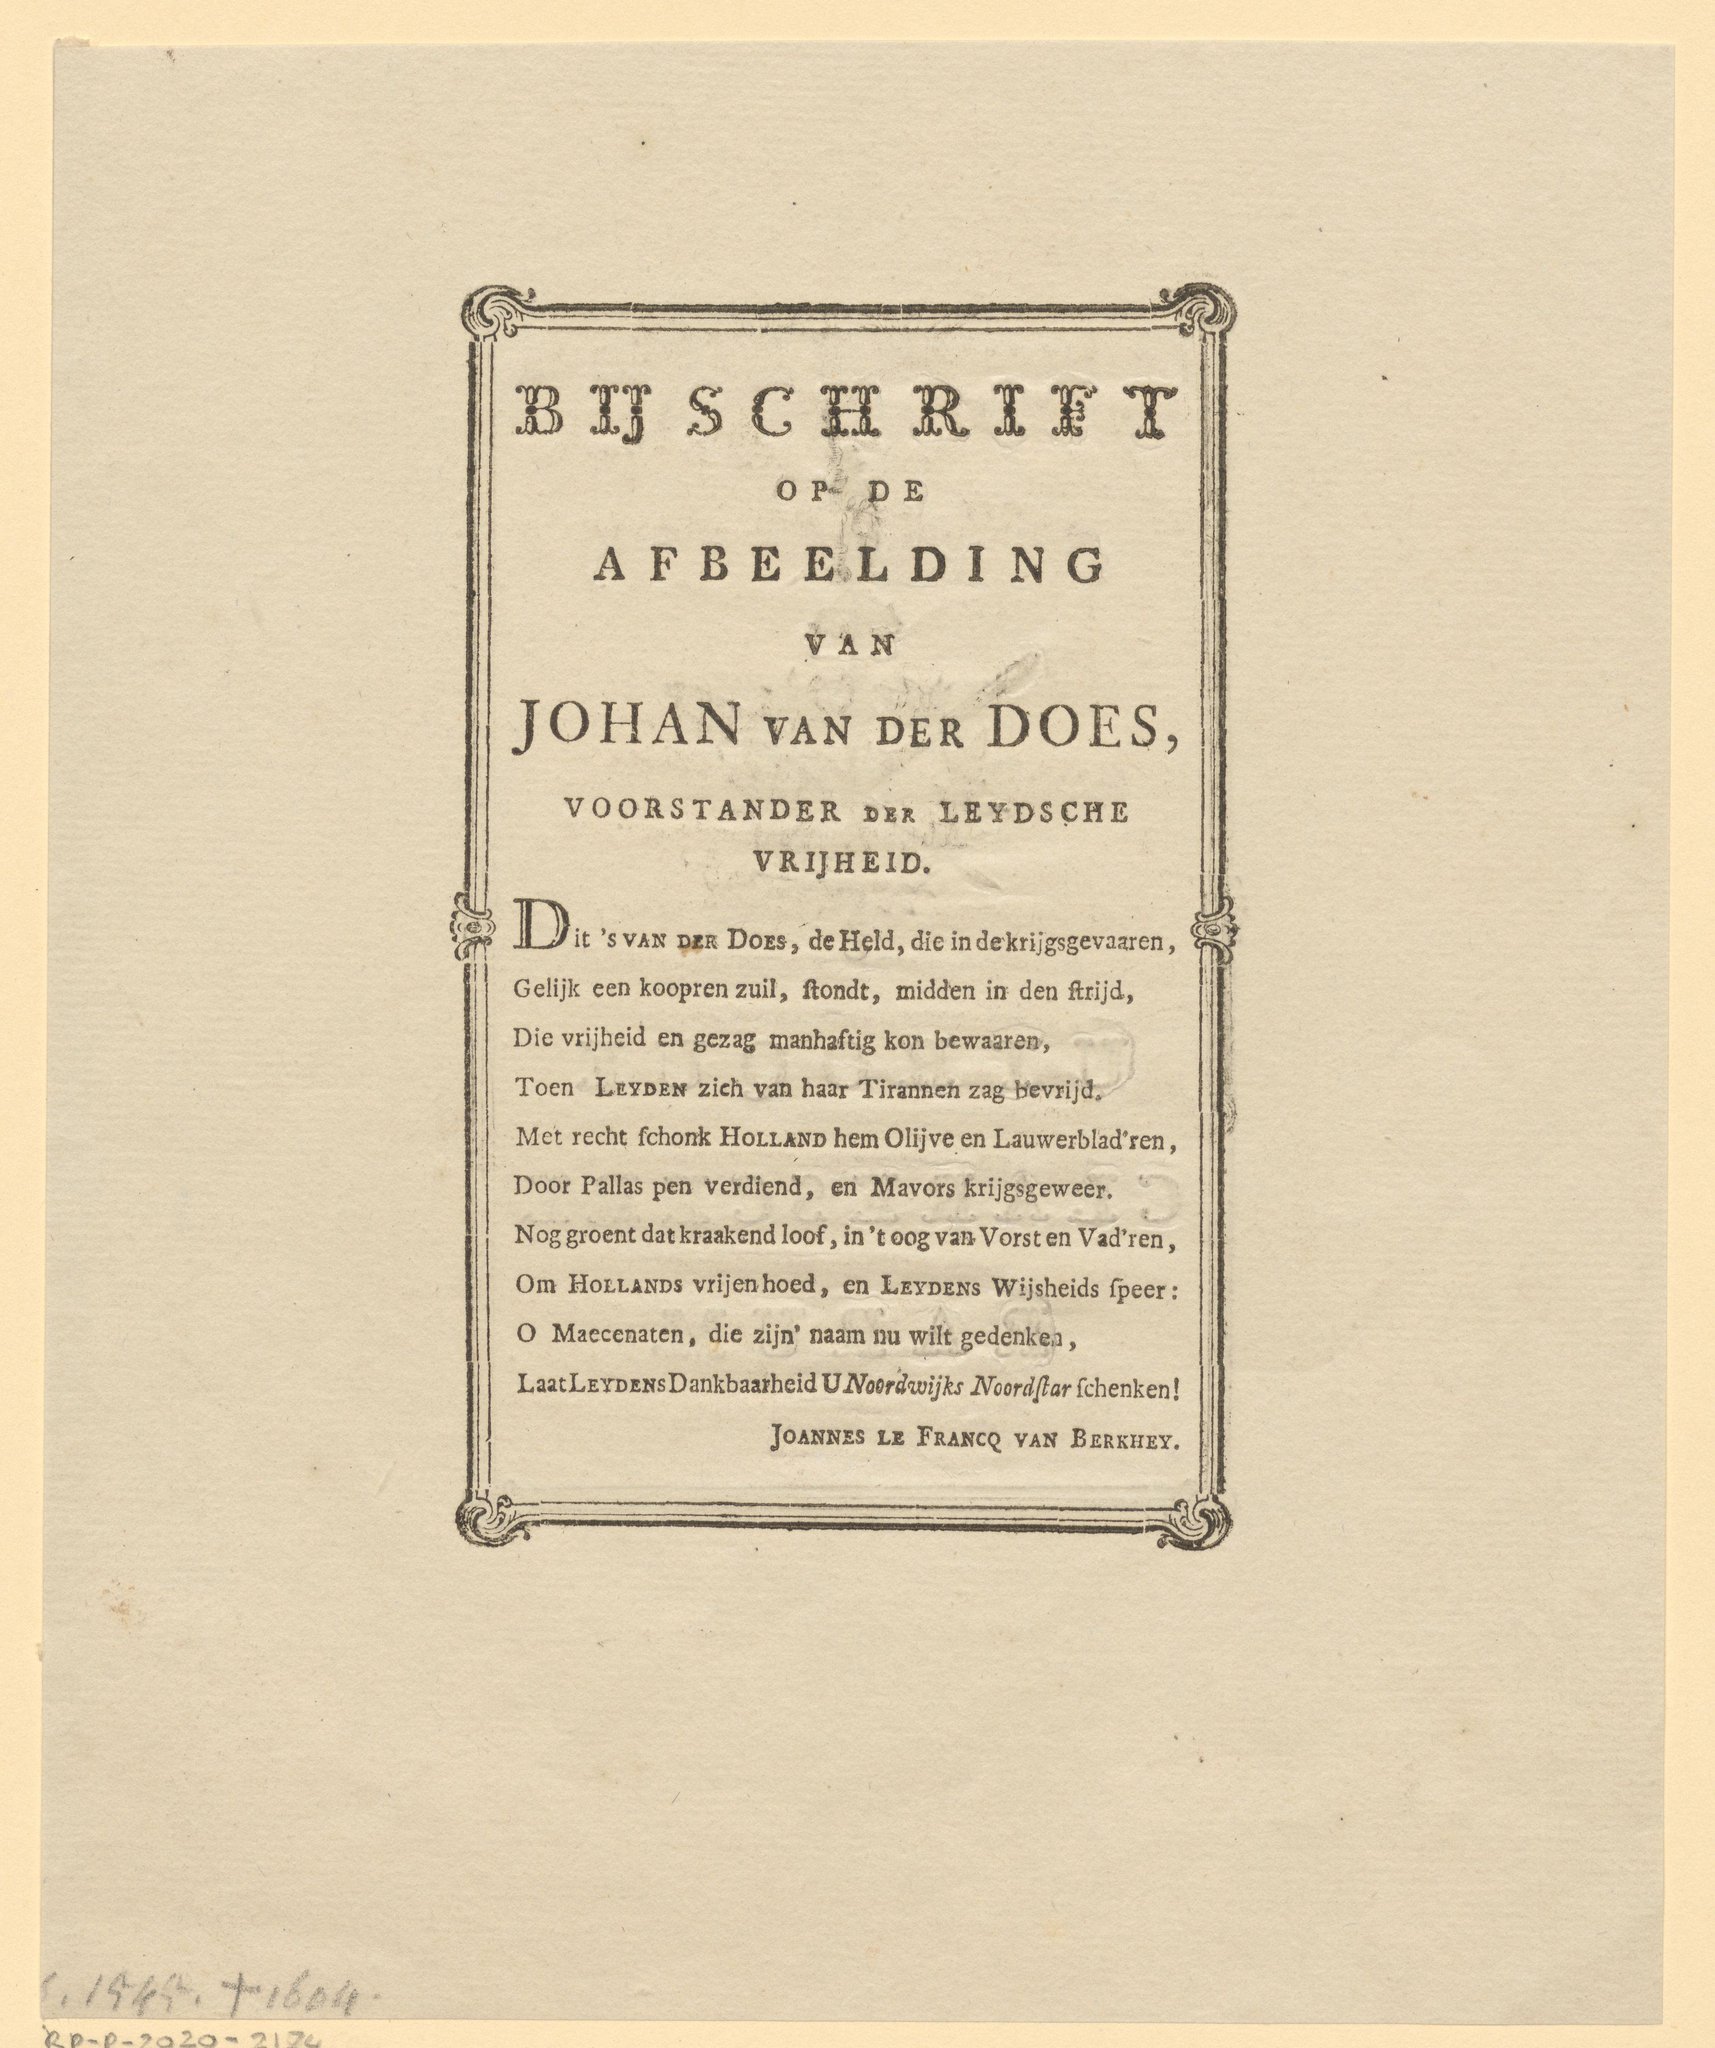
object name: text sheet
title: Tekstblad bij een portret van Jan van der Does, heer van Noordwijk en Kattendijke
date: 1774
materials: paper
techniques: letterpress printing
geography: leiden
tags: bevelhebber, dichter, filoloog, bibliothecaris, bestuurder, jan van der does (heer van noordwijk en kattendijke)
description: Tekstblad uit: Francq van Berkhey, Johannes le. Het verheerlijkt Leyden, bij het tweede eeuwgetijde van deszelfs heuchlijk ontzet (...). Leiden: Hendrik Coster, Cornelis Heyligert en Hendrik Hoogenstraten, 1774.